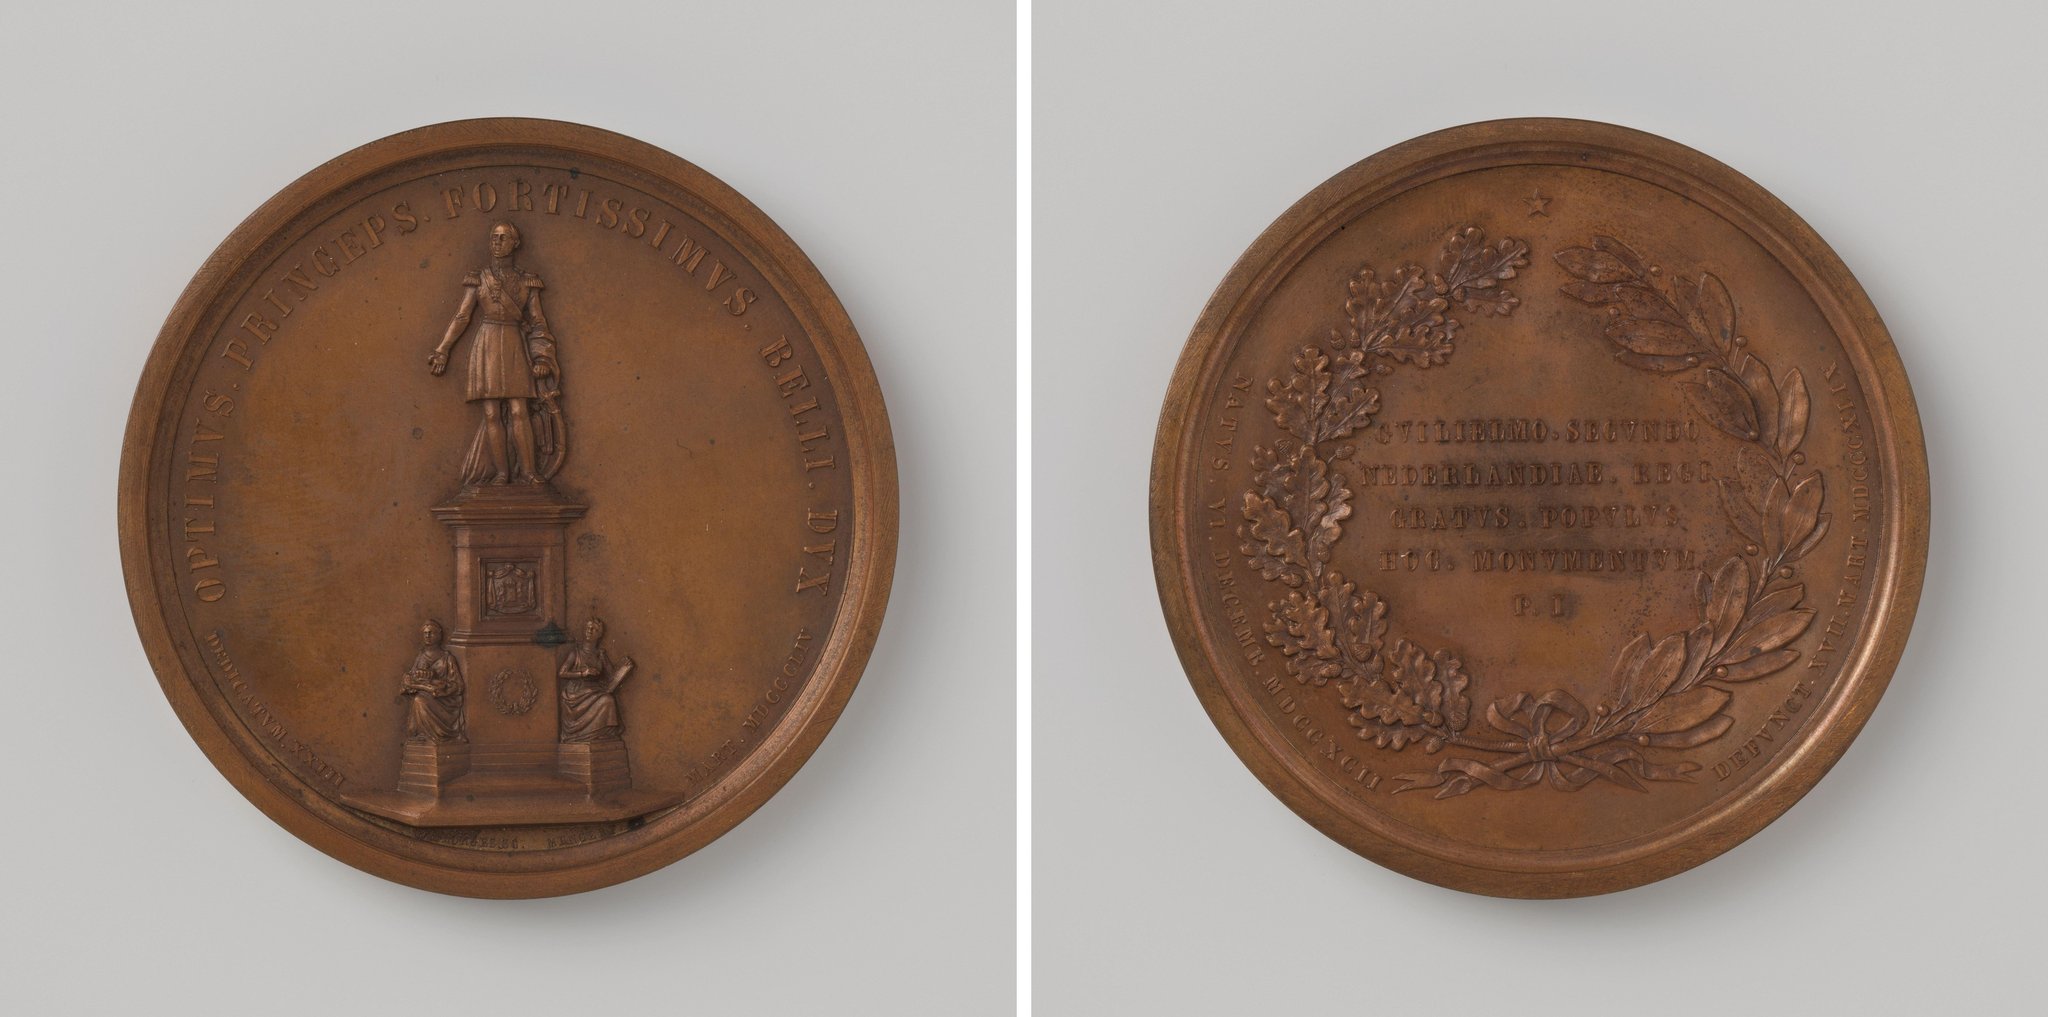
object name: history medal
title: Onthulling van het standbeeld van Koning Willem II in Den Haag 1854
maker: johan philip menger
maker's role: medailleur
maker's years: 1818-1895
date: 1854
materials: bronze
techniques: striking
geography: utrecht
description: Bronzen penning, op de voorzijde het standbeeld met omschrift, op de keerzijde vijf regels tekst tusssen samengestrikte eiken- en lauwertakken, met omschrift.